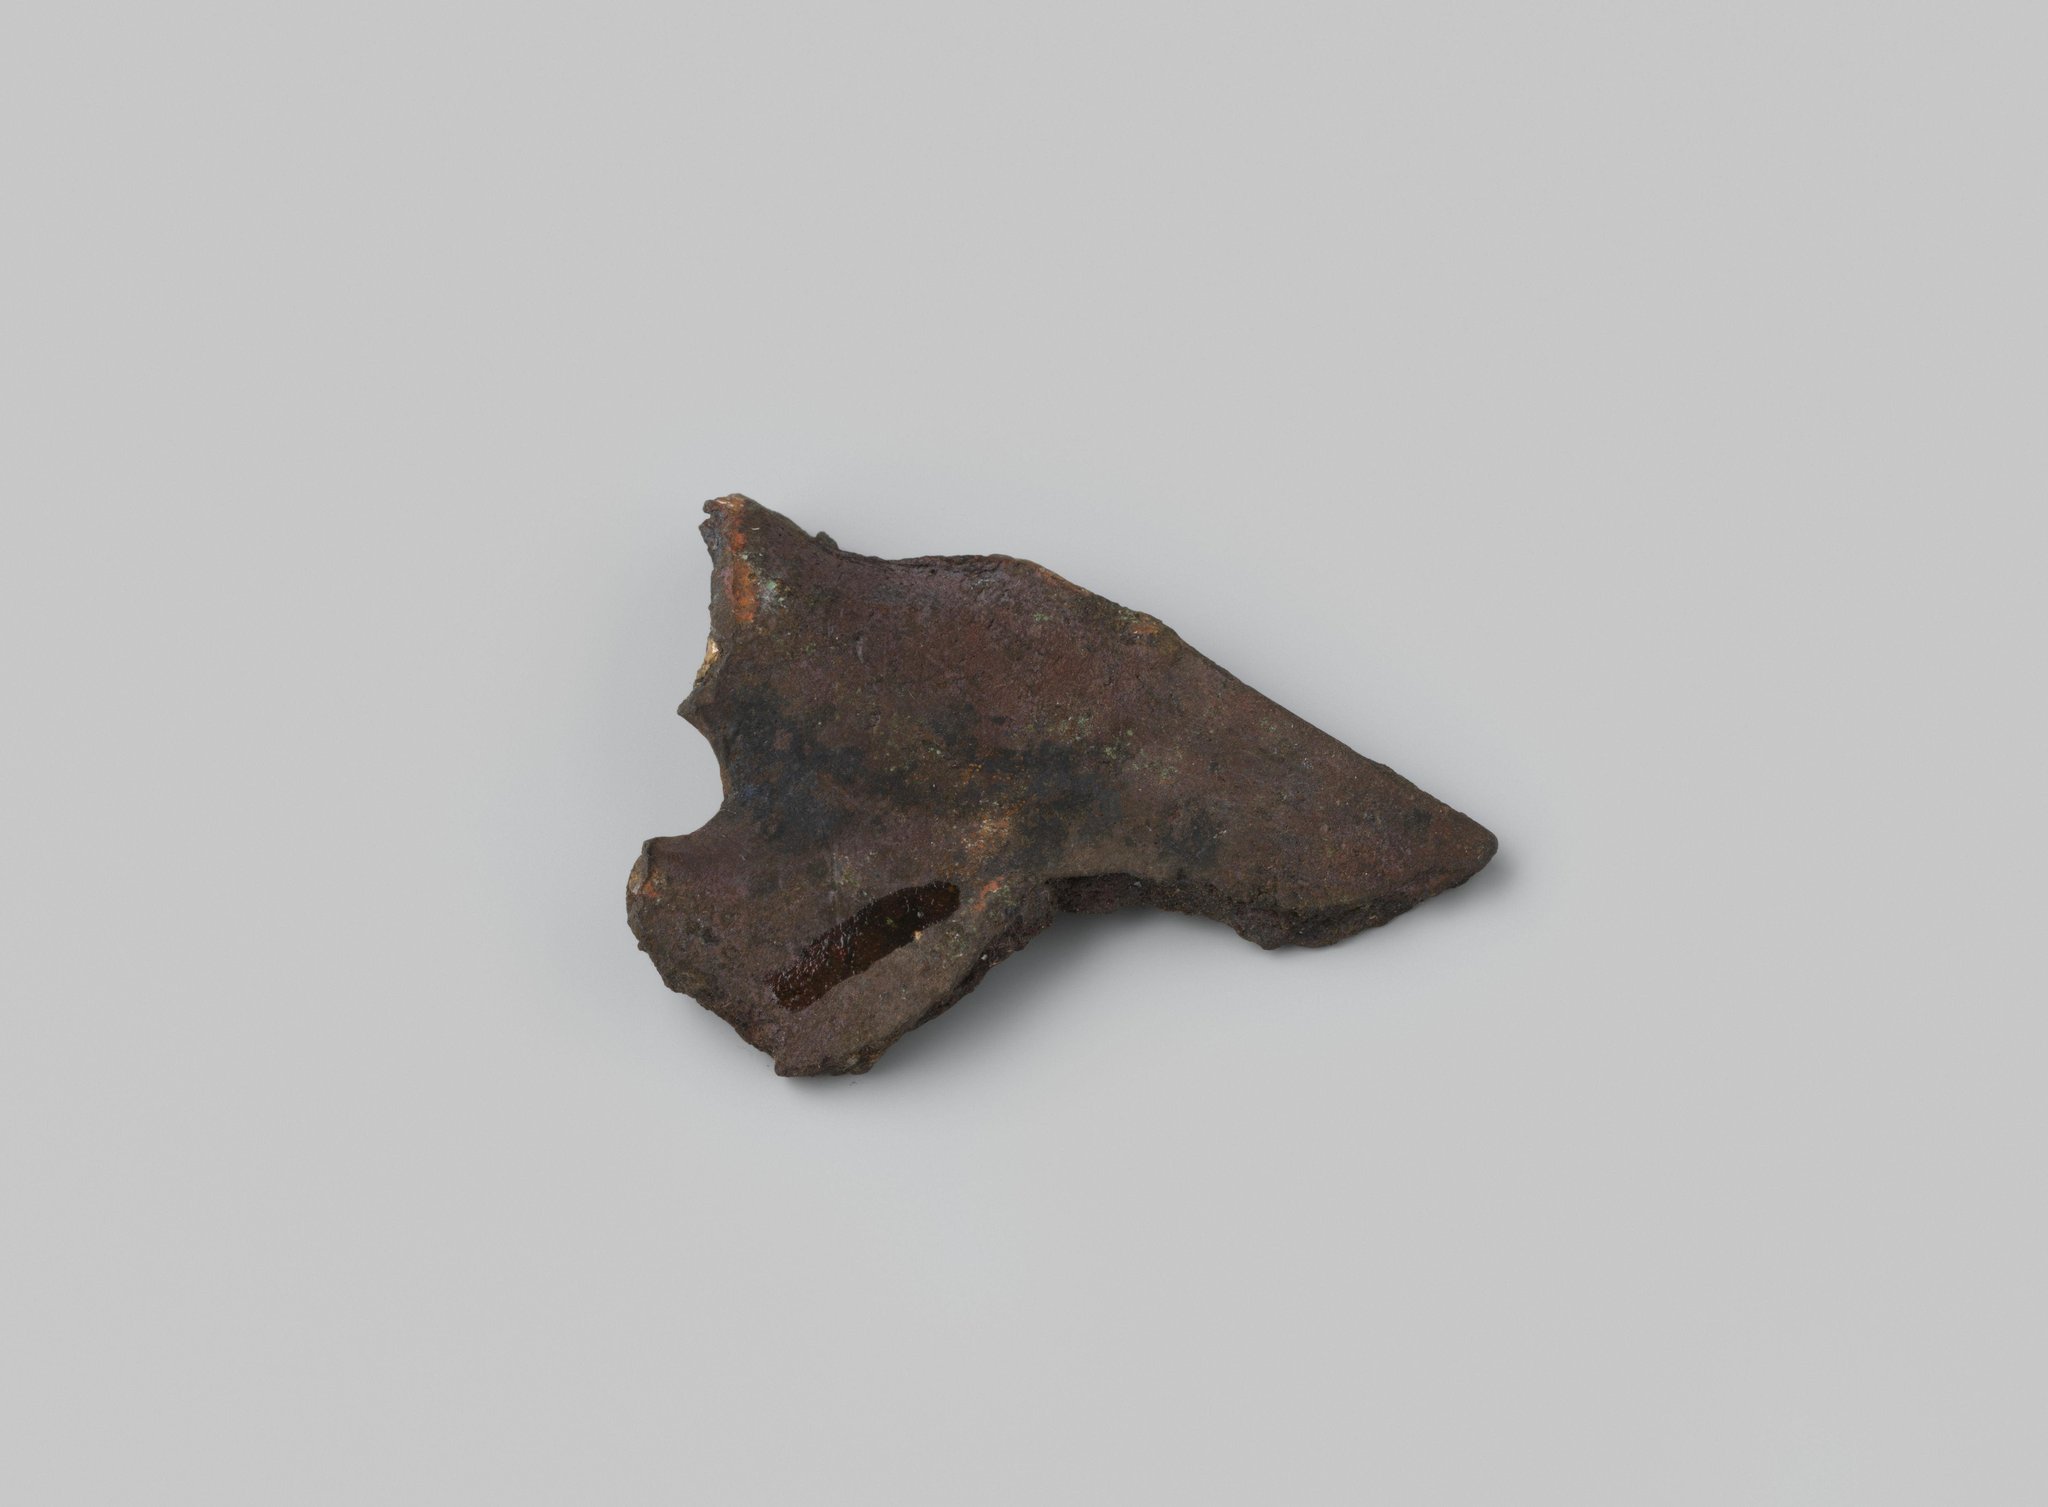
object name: part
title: Onderdeel of hulpstuk afkomstig uit het wrak van de Oost-Indiëvaarder Hollandia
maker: Anonymous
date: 1700-1743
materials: copper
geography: netherlands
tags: verenigde oostindische compagnie, hollandia (schip)